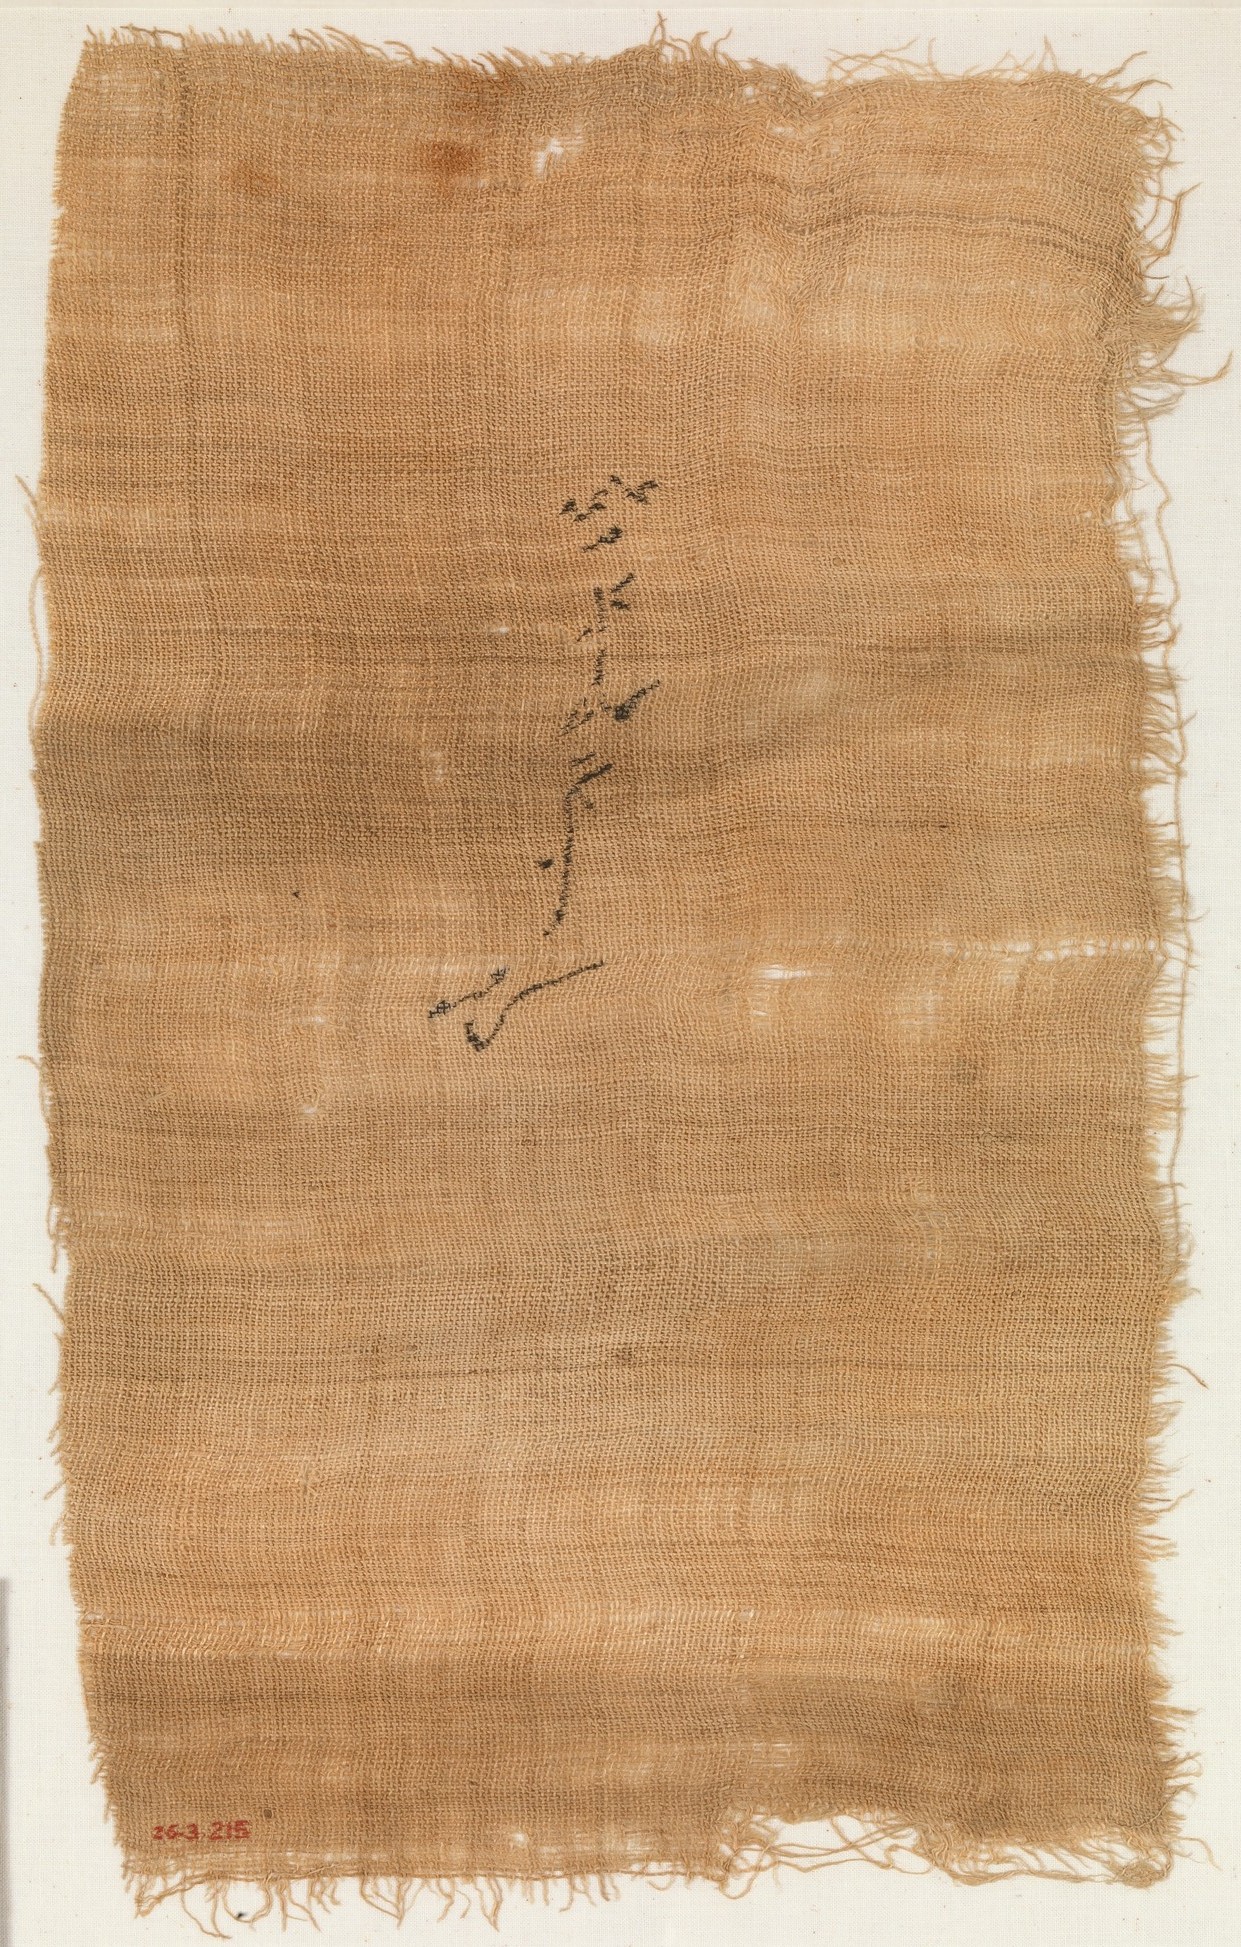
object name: linen mark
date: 1-200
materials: linen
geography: egypt